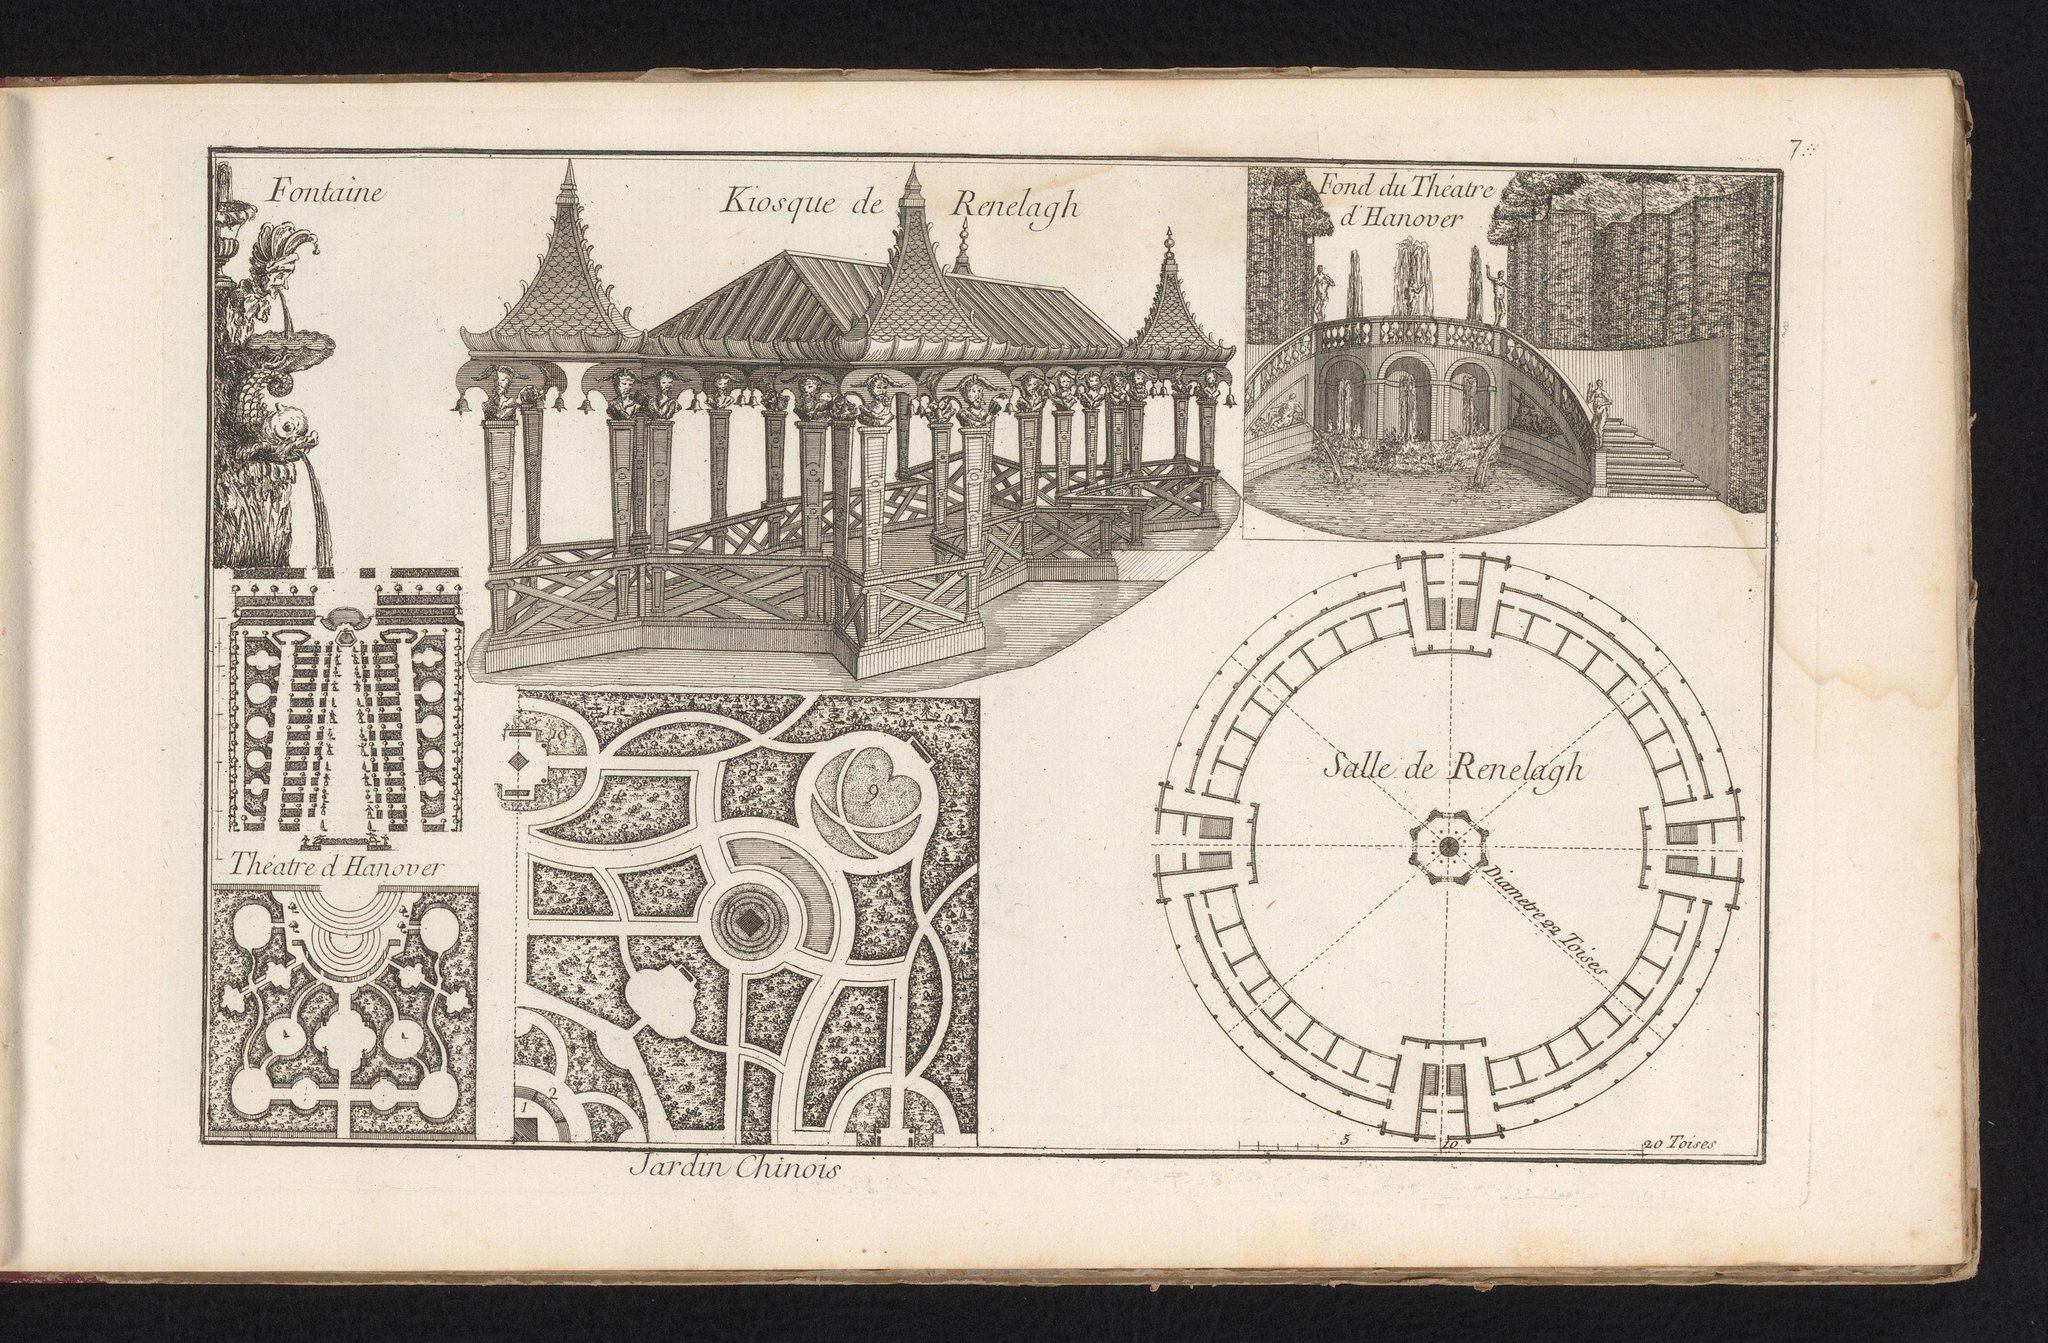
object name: print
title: Jardins anglo-chinois à la mode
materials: paper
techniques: engraving, etching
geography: paris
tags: plan, map of garden, garden fountain, lay-out of garden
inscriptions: collector's mark: Lugt 2760, collector's mark: Lugt 2228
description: De serie 'Jardins anglo-chinois à la mode' verscheen in totaal in 21 zogeheten 'cahiers' (afleveringen). De huidige prent komt uit het zesde 'cahier'. Het Rijksmuseum Amsterdam bezit drie banden met daarin in totaal zes 'cahiers' van deze reeks. In de documentatie wordt verwezen naar een in de bibliotheek van het Rijksmuseum Amsterdam aanwezige facsimile van het complete werk.